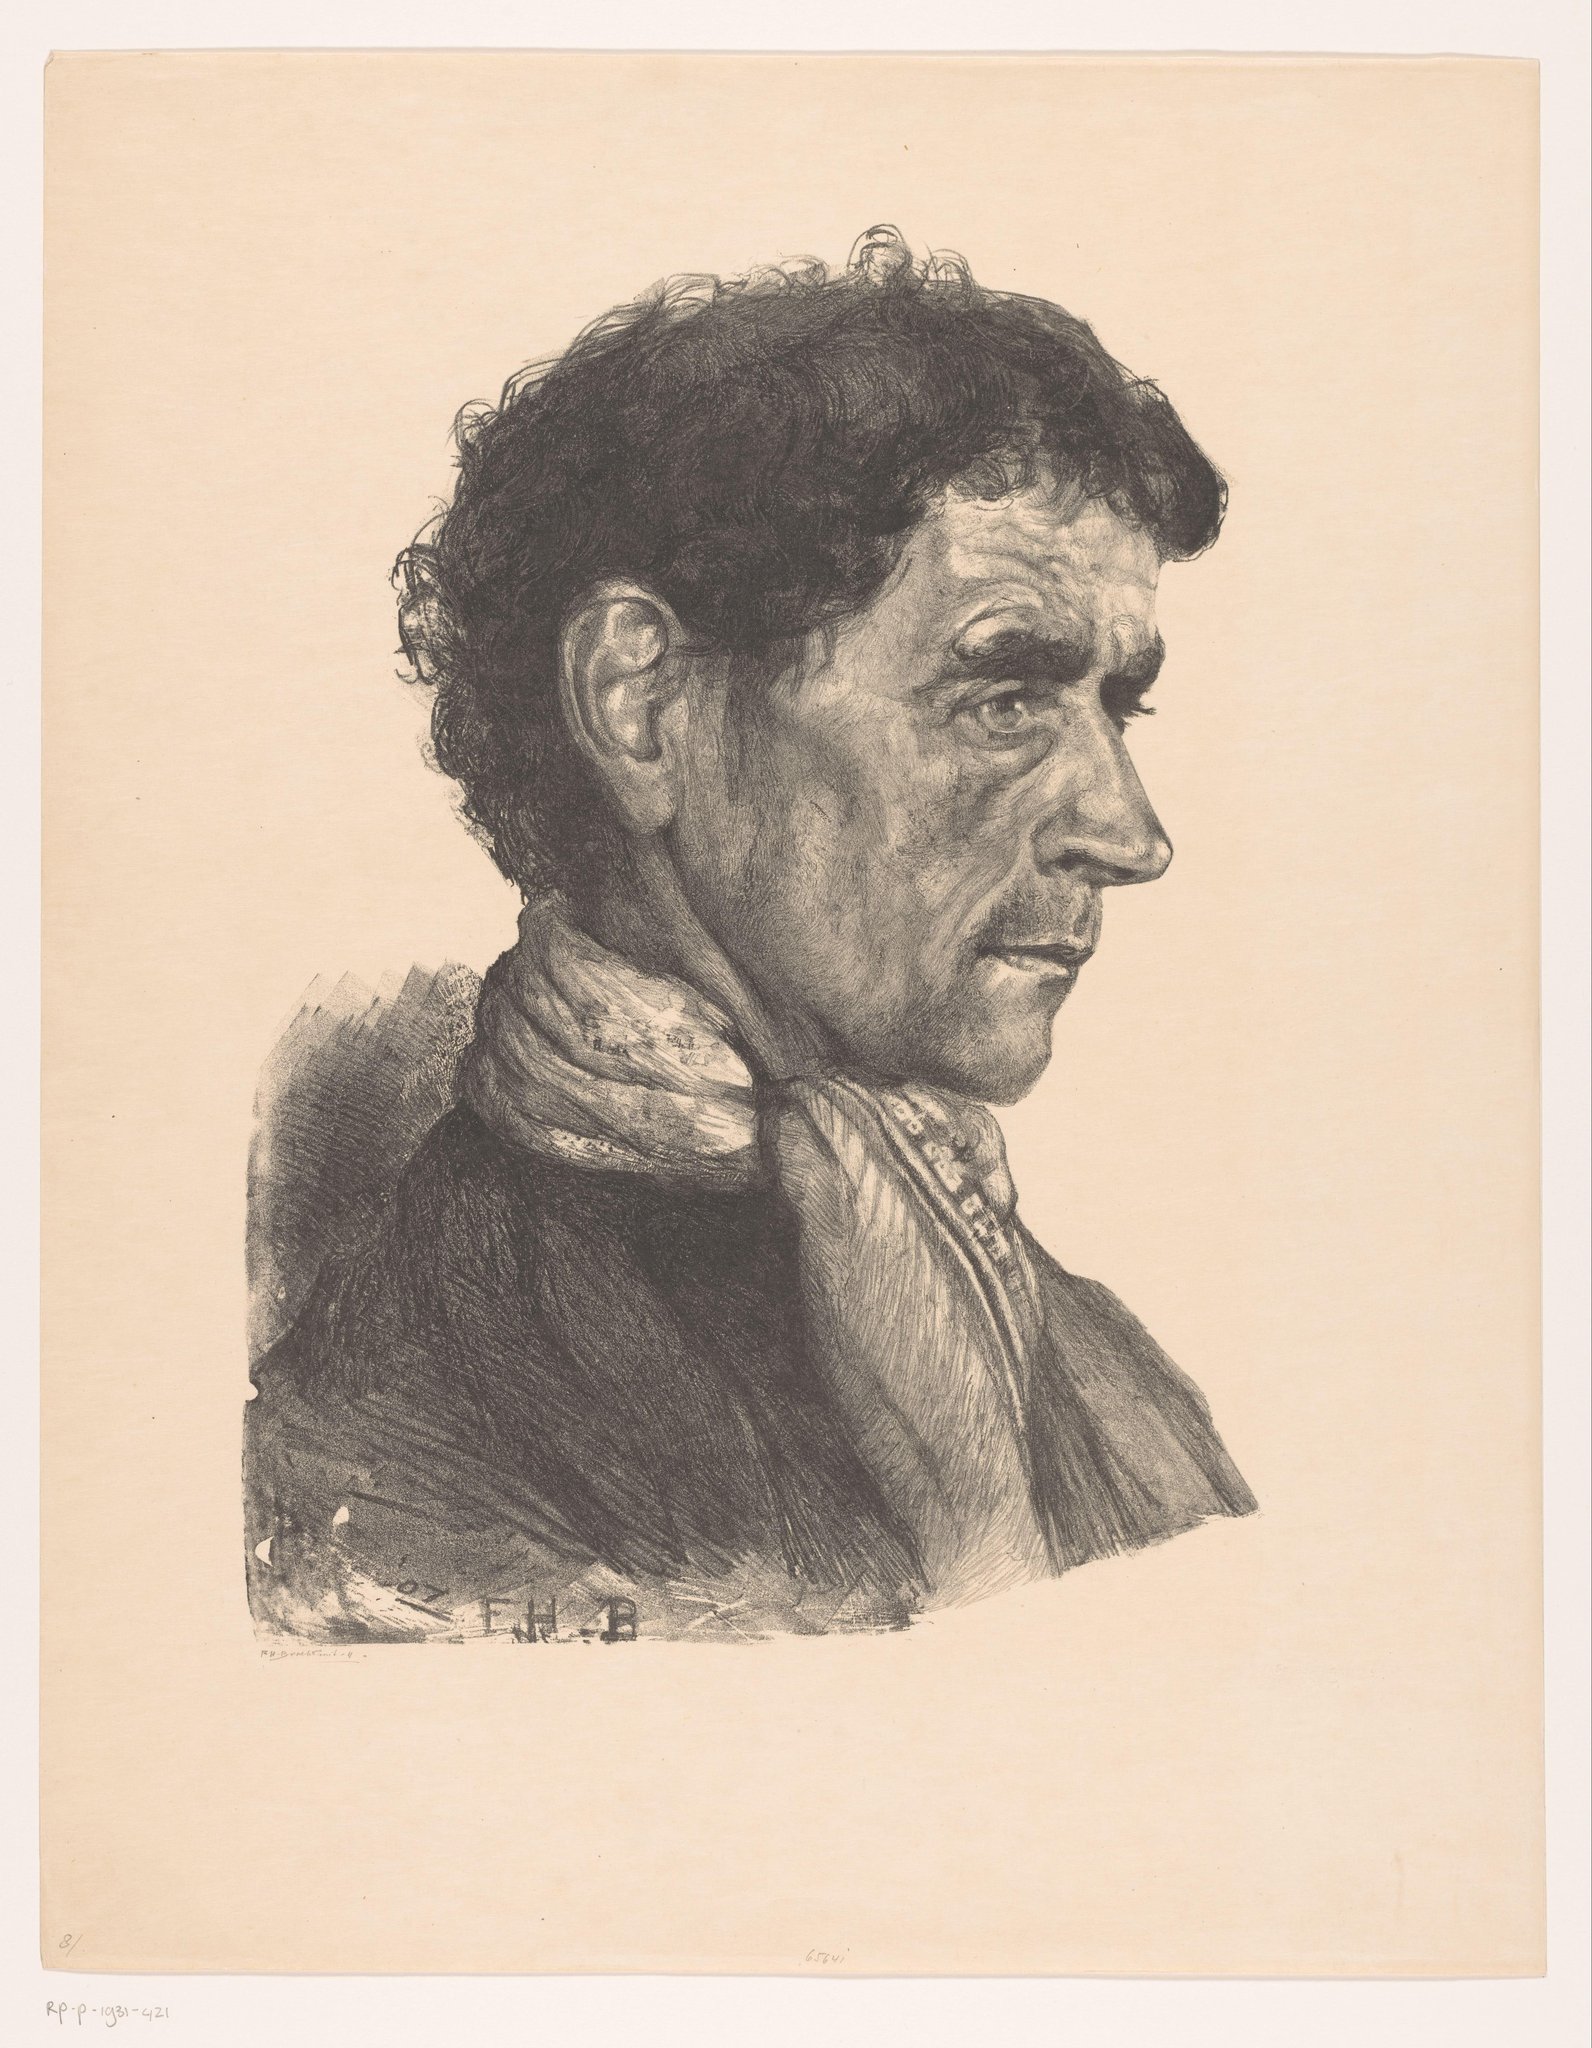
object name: print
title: Portret van de Katwijkse visser Jacob van Duyvenvoorde, bijgenaamd het Stiertje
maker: frederika henriëtte broeksmit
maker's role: draughtsman, print maker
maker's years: 1875-1945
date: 1907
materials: paper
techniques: lithograph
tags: historical persons, fisherman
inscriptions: collector's mark: Lugt 2228, inscription: ‘8/’